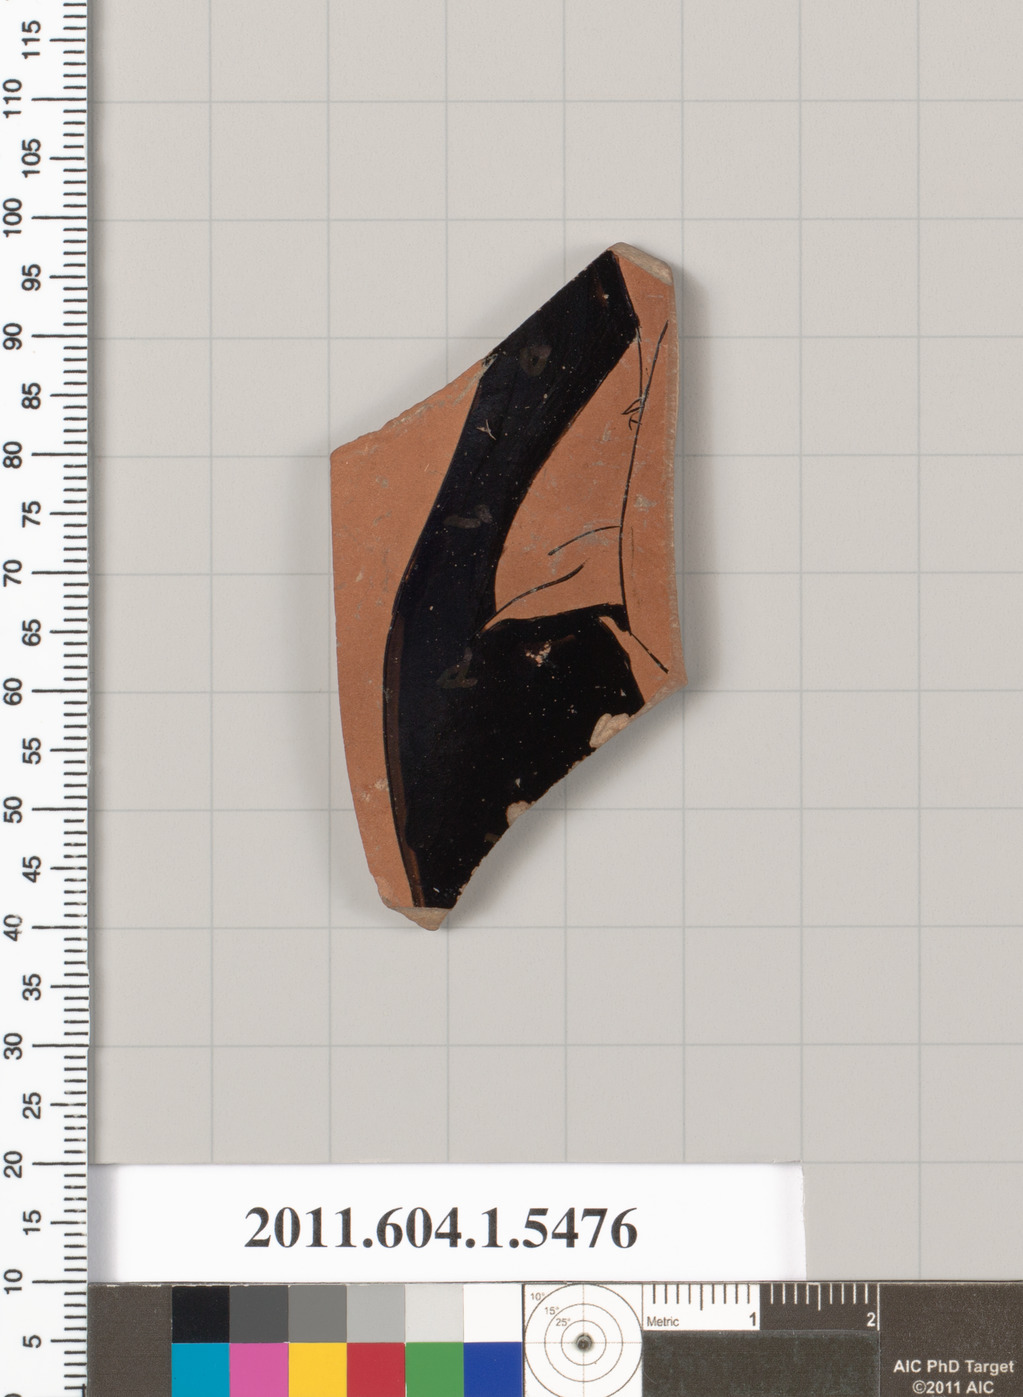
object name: kylix fragment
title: Terracotta fragment of a kylix (drinking cup)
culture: greek, attic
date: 500-480 BCE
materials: terracotta